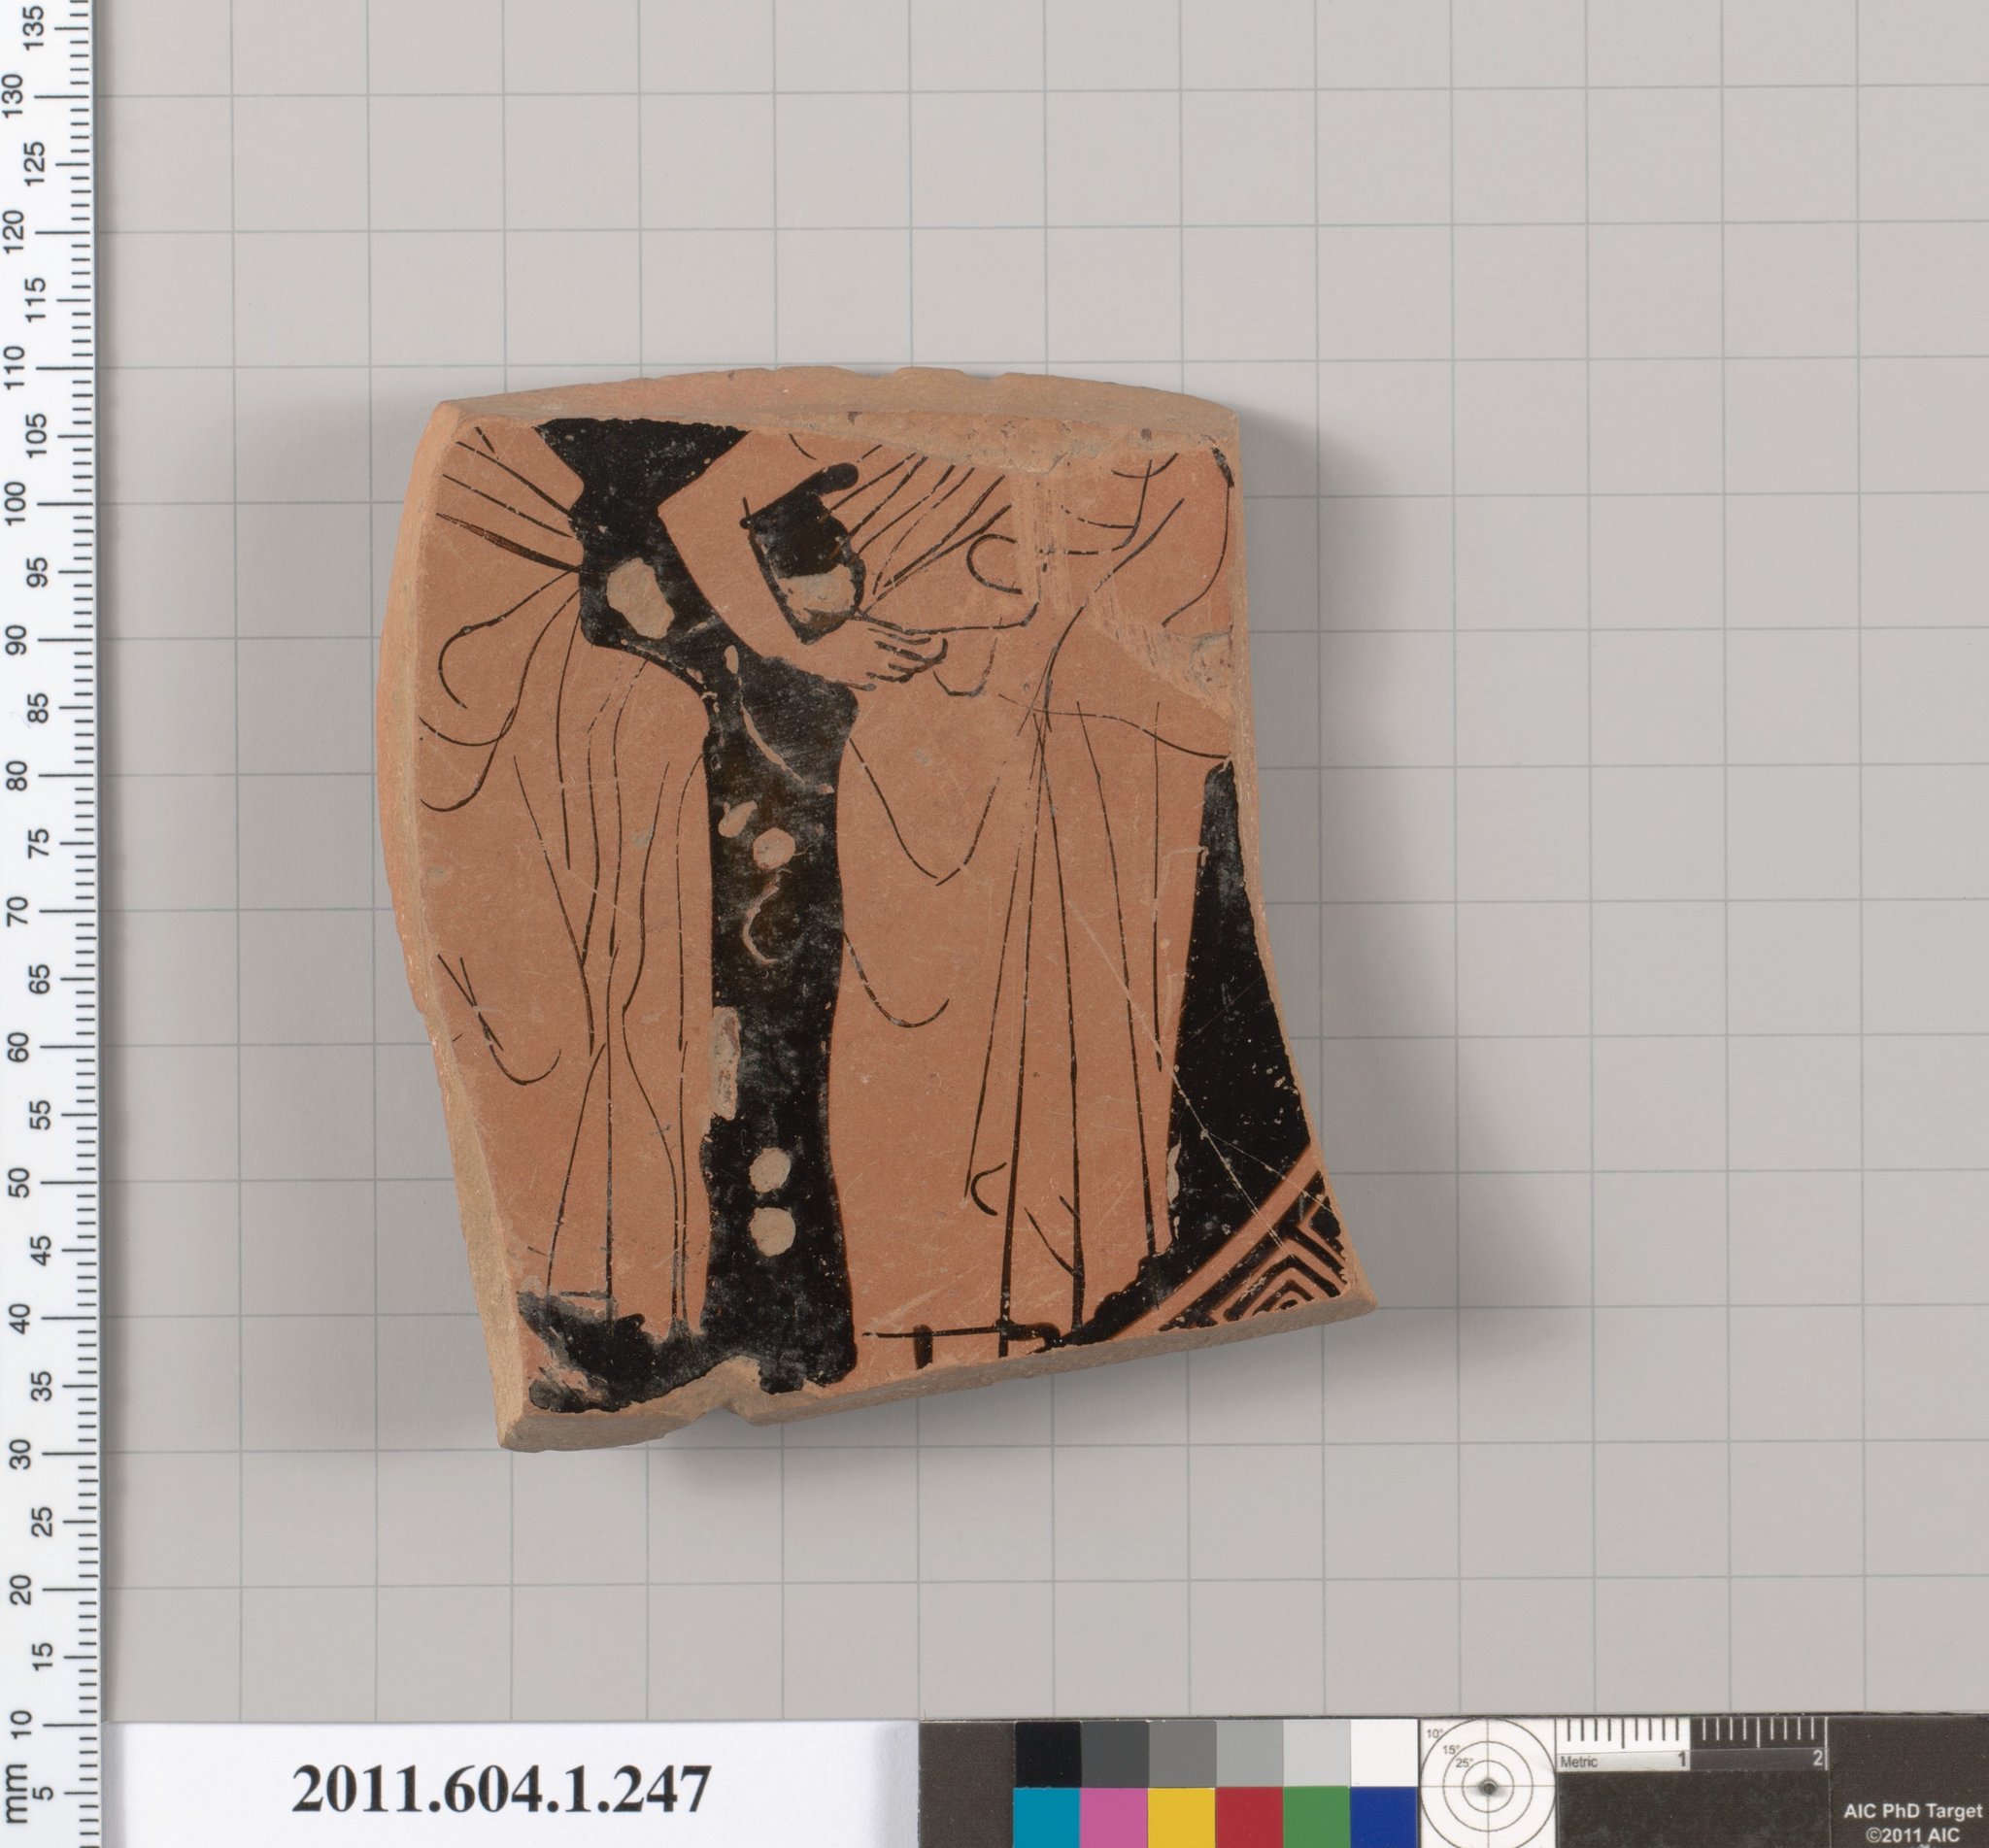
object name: kylix fragment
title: Terracotta fragment of a kylix (drinking cup)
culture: greek, attic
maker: painter of faina 103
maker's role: artist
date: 475-451 BCE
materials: terracotta